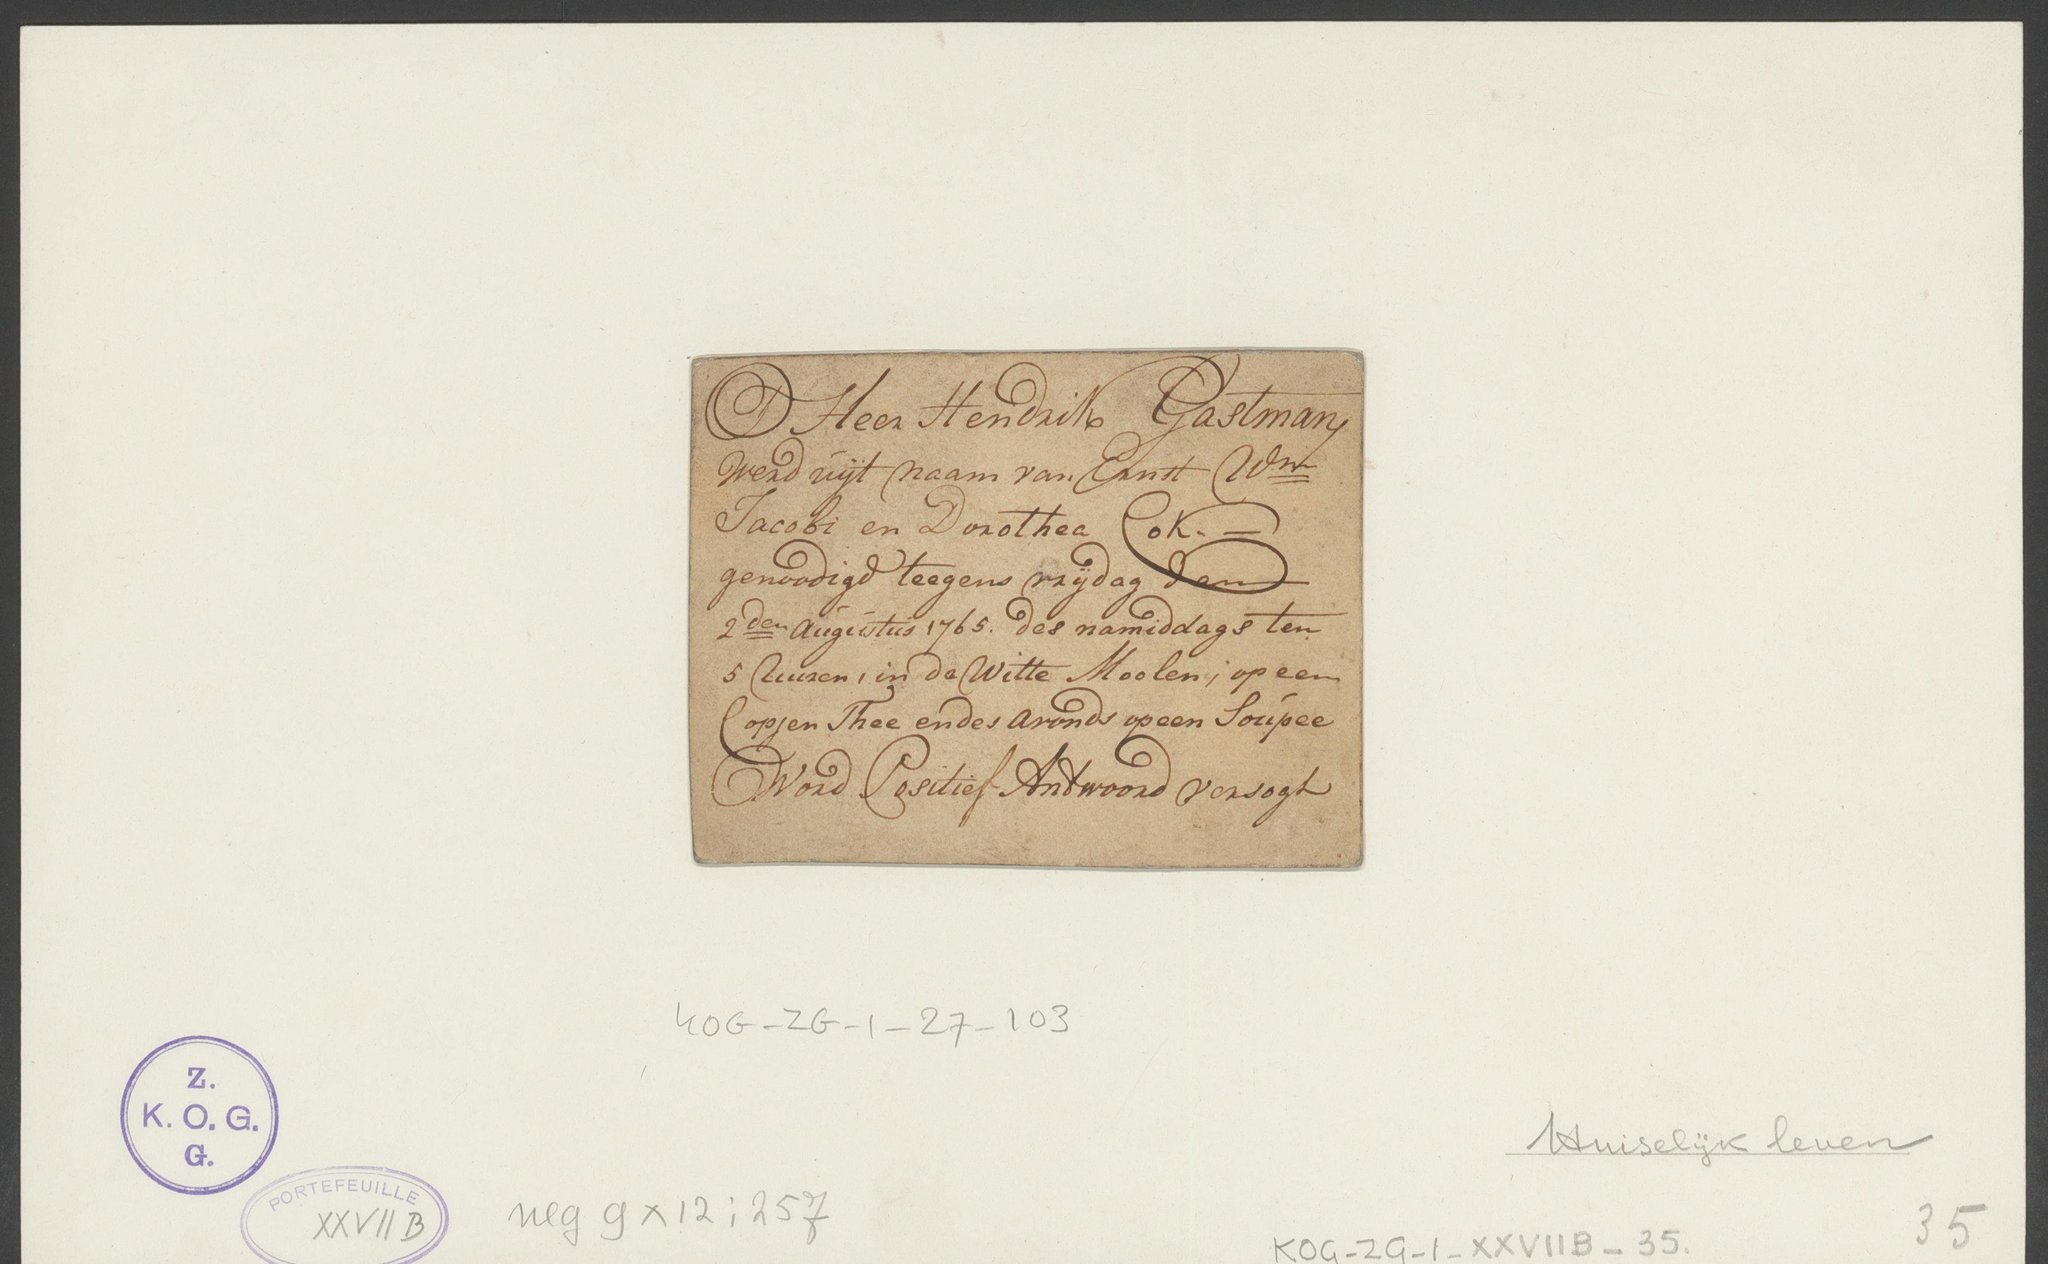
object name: manuscript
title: Uitnodiging voor de thee, 1765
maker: Anonymous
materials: cardboard, ink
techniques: pen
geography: netherlands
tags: visiting; receiving guests; elegant company, tea (leaves)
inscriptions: collector's mark, collector's mark: Lugt 1641